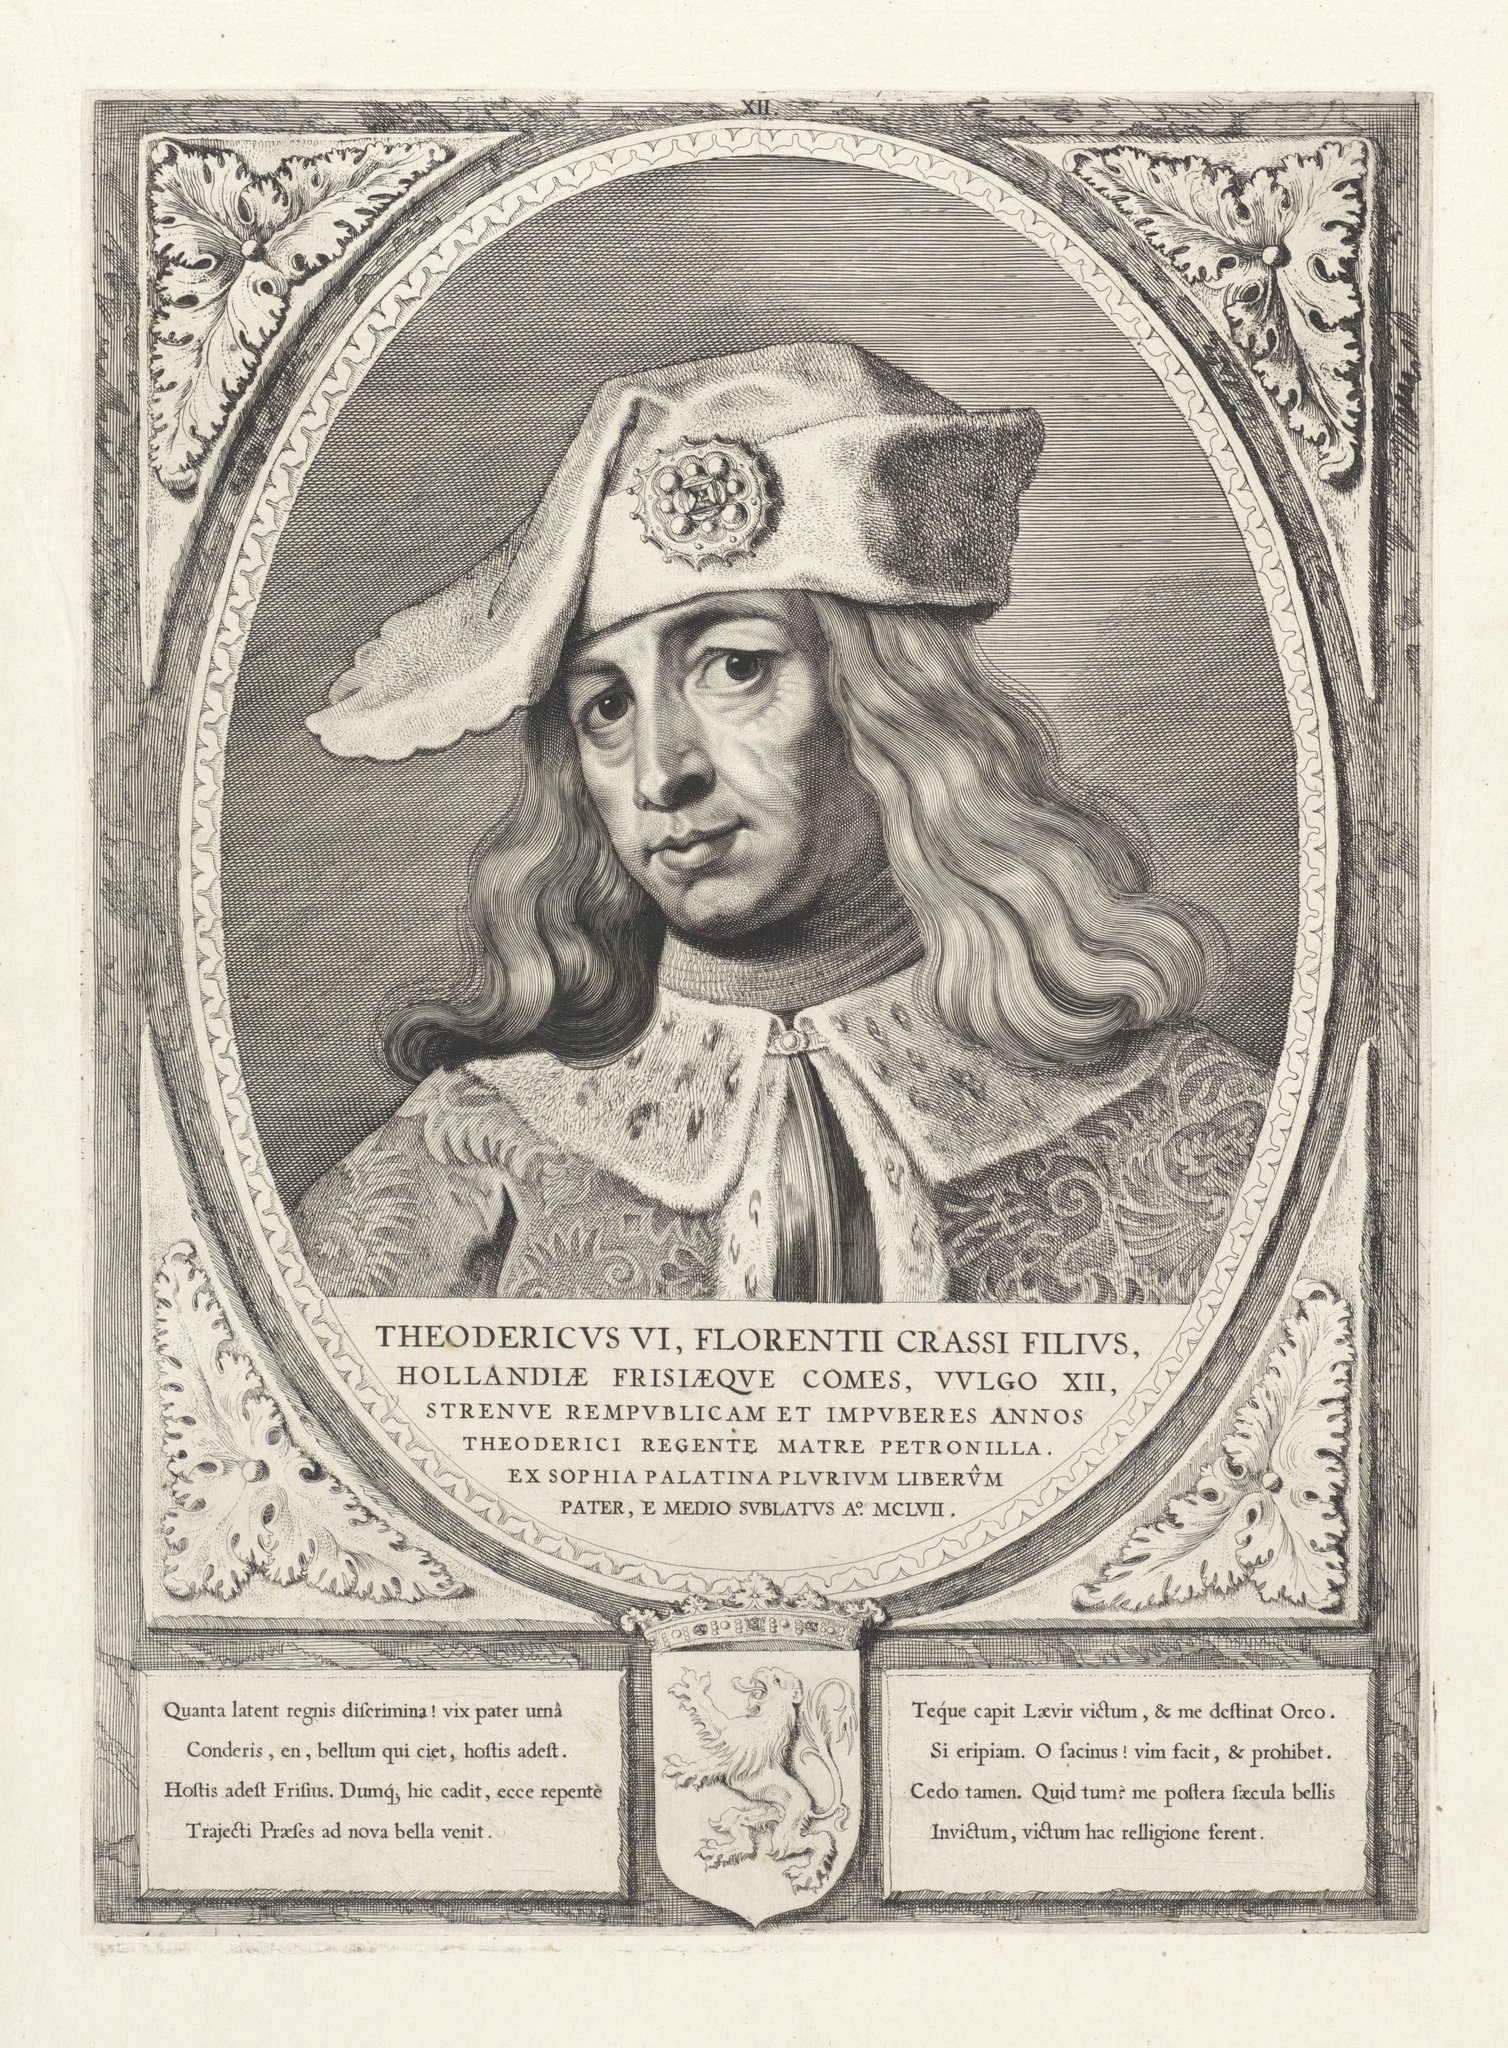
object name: print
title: Theodoricvs VI, Florentii Crassi Filivs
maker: cornelis visscher (ii)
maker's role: draughtsman, painter, print maker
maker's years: 1628-1658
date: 1650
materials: paper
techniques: engraving, etching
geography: haarlem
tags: dirk vi (graaf van holland)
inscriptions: collector's mark: Lugt 12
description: Dirk VI, graaf van Holland, met een met parels en edelstenen verfraaide hoofddeksel. De omlijsting is versierd met het wapen van Holland.